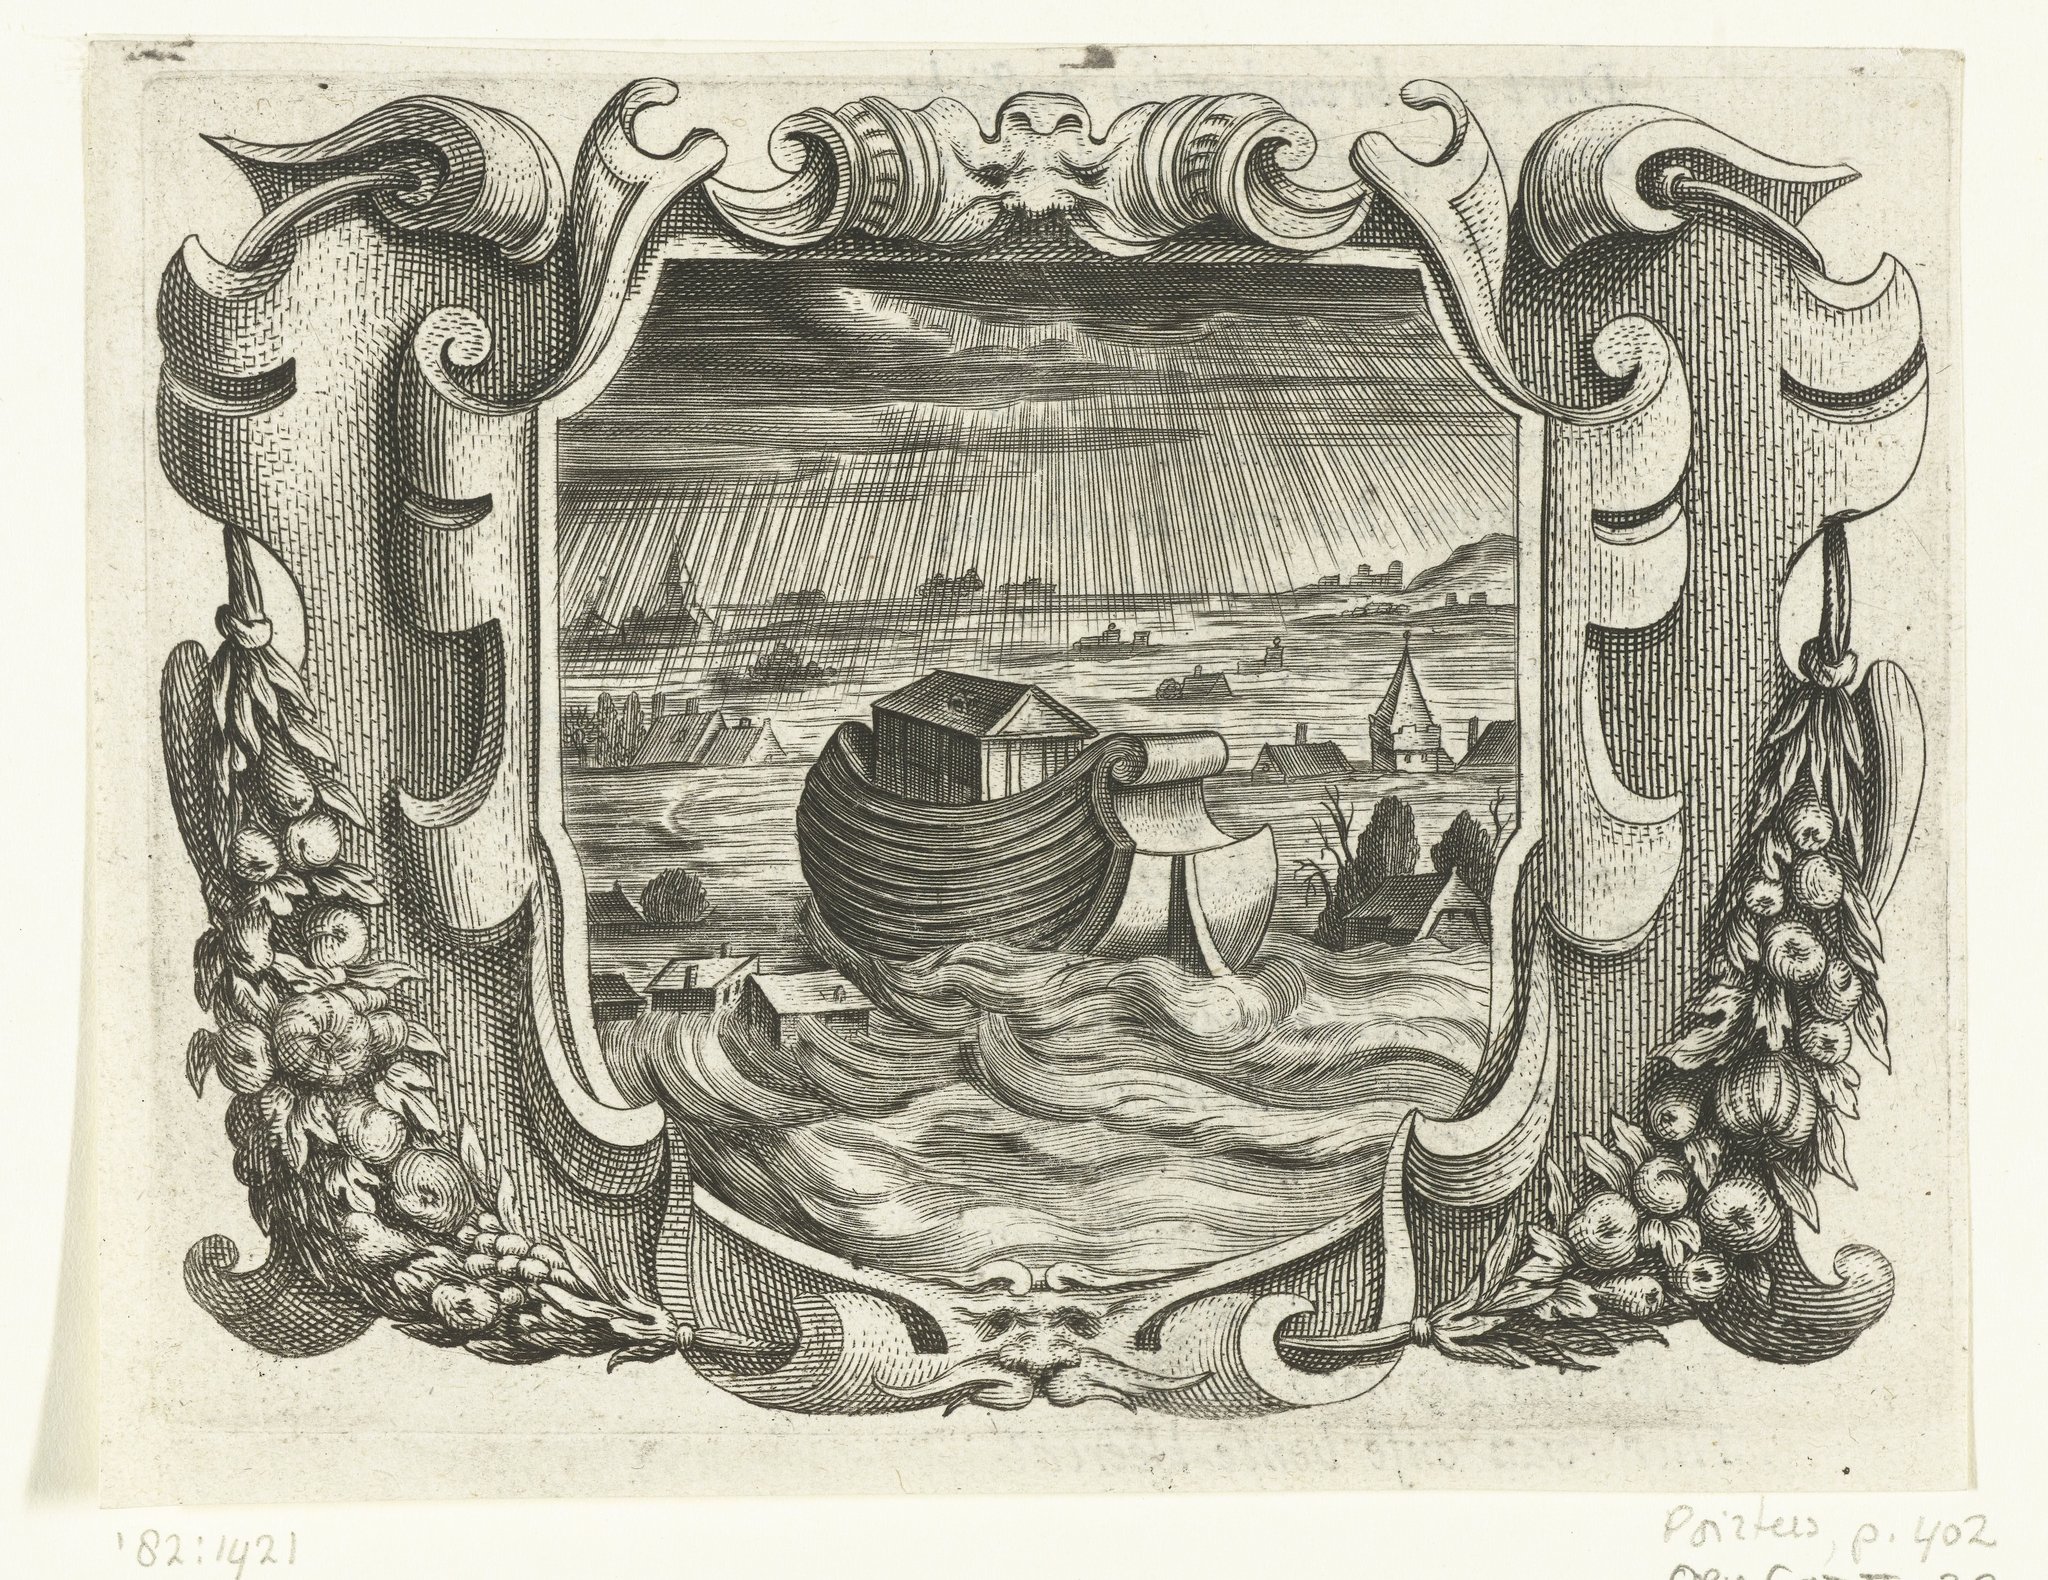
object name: print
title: Afbeeldinghe van d'eerste eeuwe der Societeit Iesv voor ooghen ghestelt door de Duyts-Nederlantsche Provincie der selver Societeyt.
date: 1640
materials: paper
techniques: engraving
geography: antwerp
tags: the building of the ark, and the embarkation (genesis 7:5-9)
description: Uit serie van 38 cartouches, gedecoreerd met maskers, guirlandes van fruit en bloemen, schelpen en dieren.